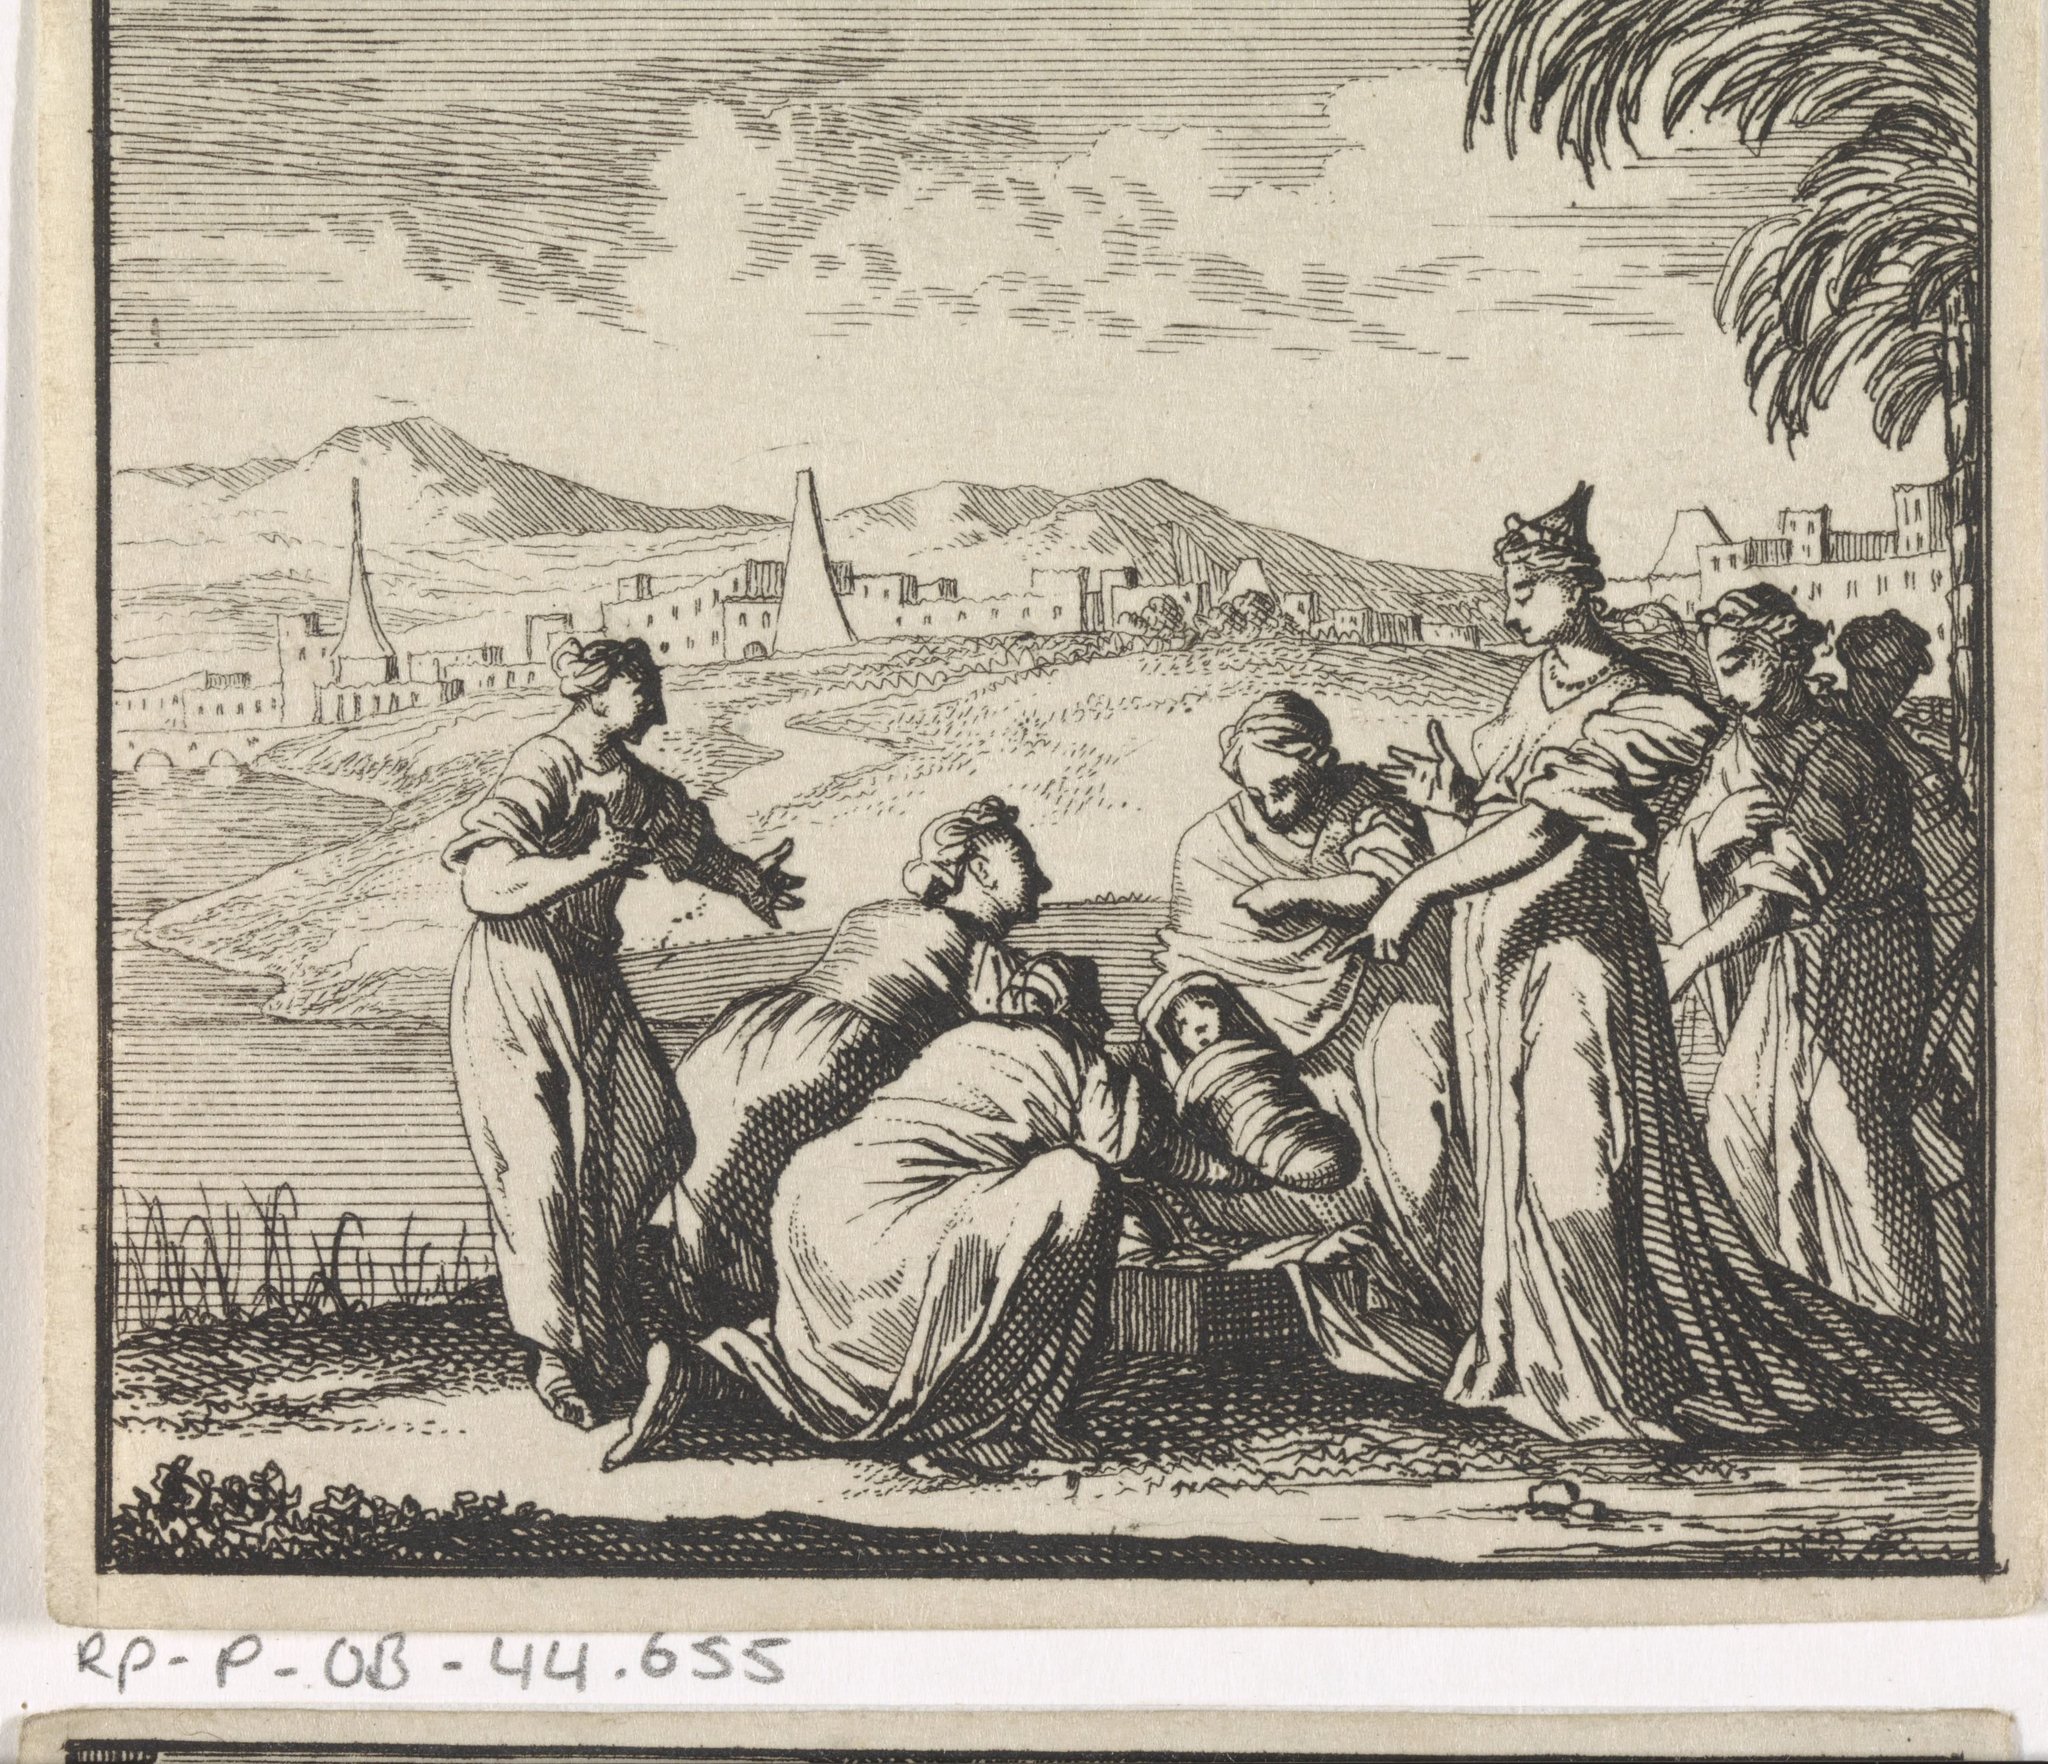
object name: print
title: Mozes gevonden door de dochter van de farao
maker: caspar luyken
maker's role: draughtsman, print maker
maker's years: 1672-1708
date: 1698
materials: paper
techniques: etching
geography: amsterdam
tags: the finding of moses: pharaoh's daughter comes to bathe with her maidens in the river and discovers the child floating on the water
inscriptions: collector's mark: Lugt 2228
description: Proefdruk van illustratie uit: Josephus, Flavius. XX. boeken van de oude geschiedenissen der joden, 4 delen. Amsterdam: Barent Visscher, Willem de Coup, Willem van Lamsveld, Andries van Damme, 1698, dl. I.